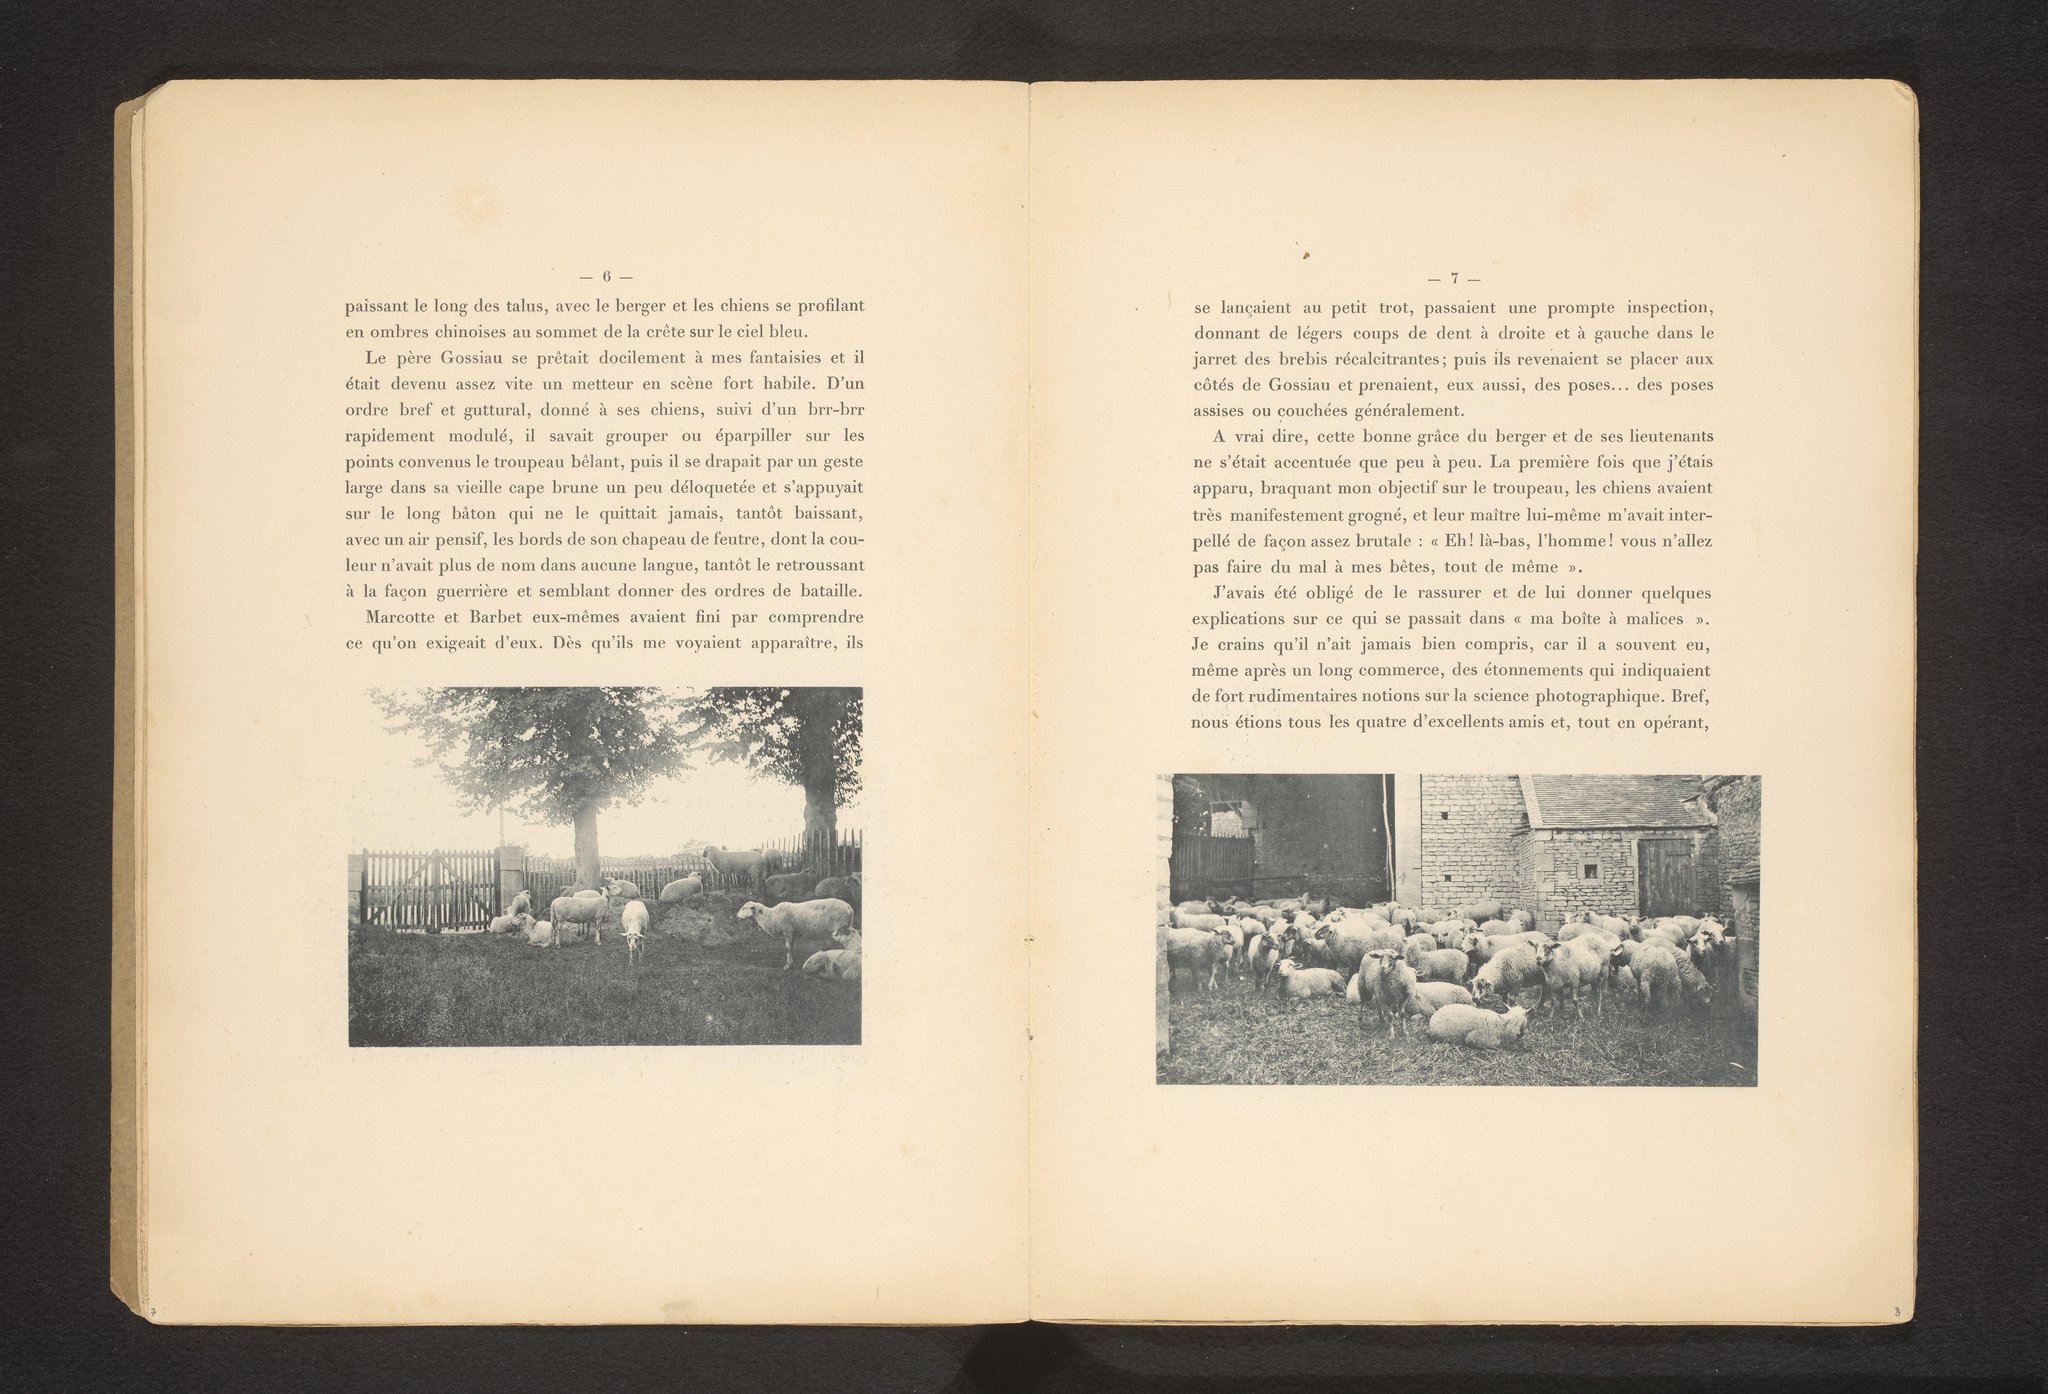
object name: photomechanical print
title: Kudde schapen voor een hek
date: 1885-1895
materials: paper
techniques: photograph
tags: sheep, cattle-breeding, livestock industry